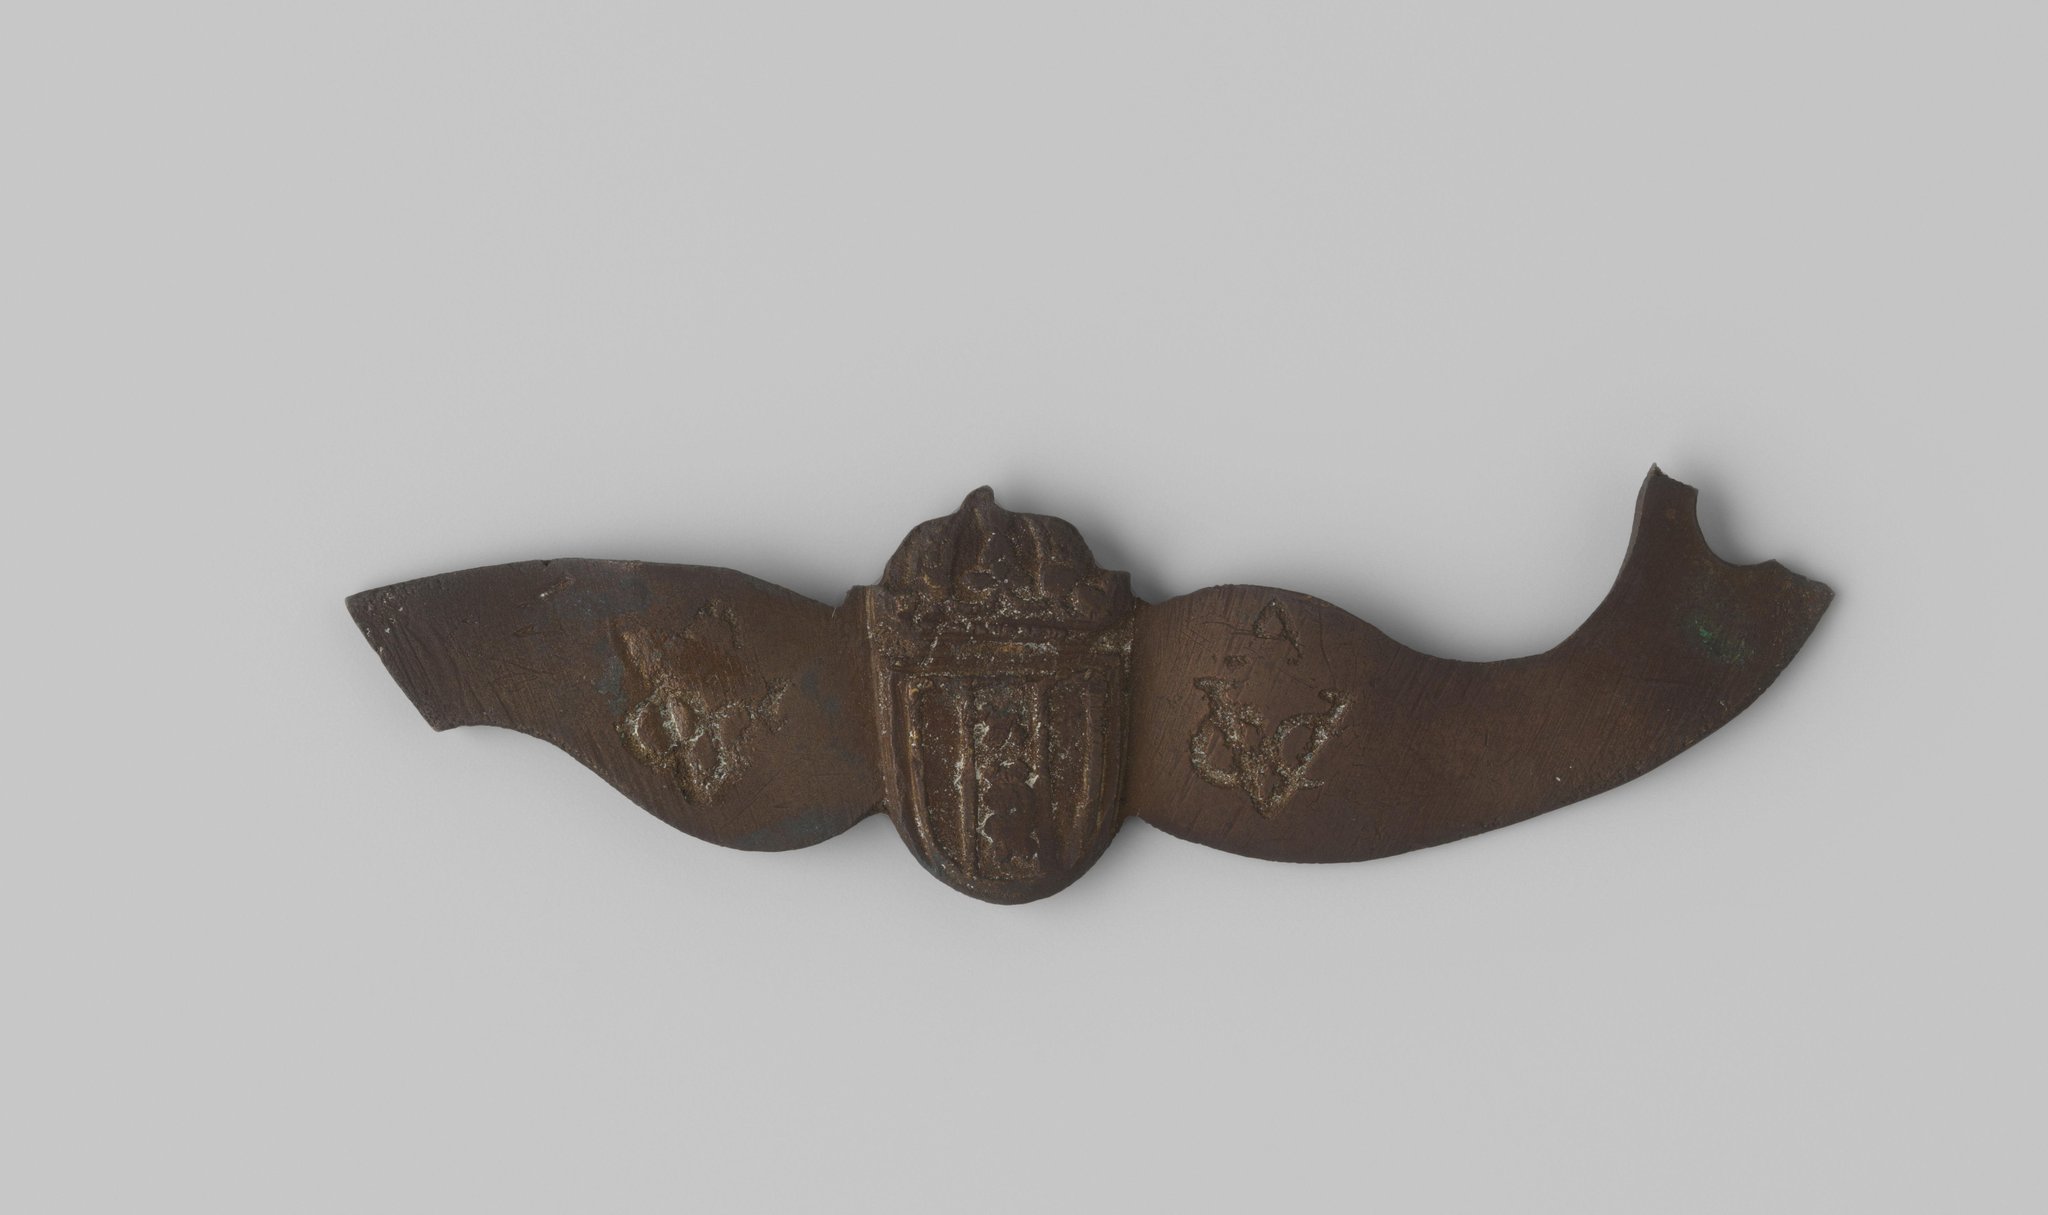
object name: musket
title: Schroefplaat van een musket uit het wrak van de Oost-Indiëvaarder Hollandia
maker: Anonymous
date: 1700-1743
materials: copper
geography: netherlands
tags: verenigde oostindische compagnie, hollandia (schip), annet